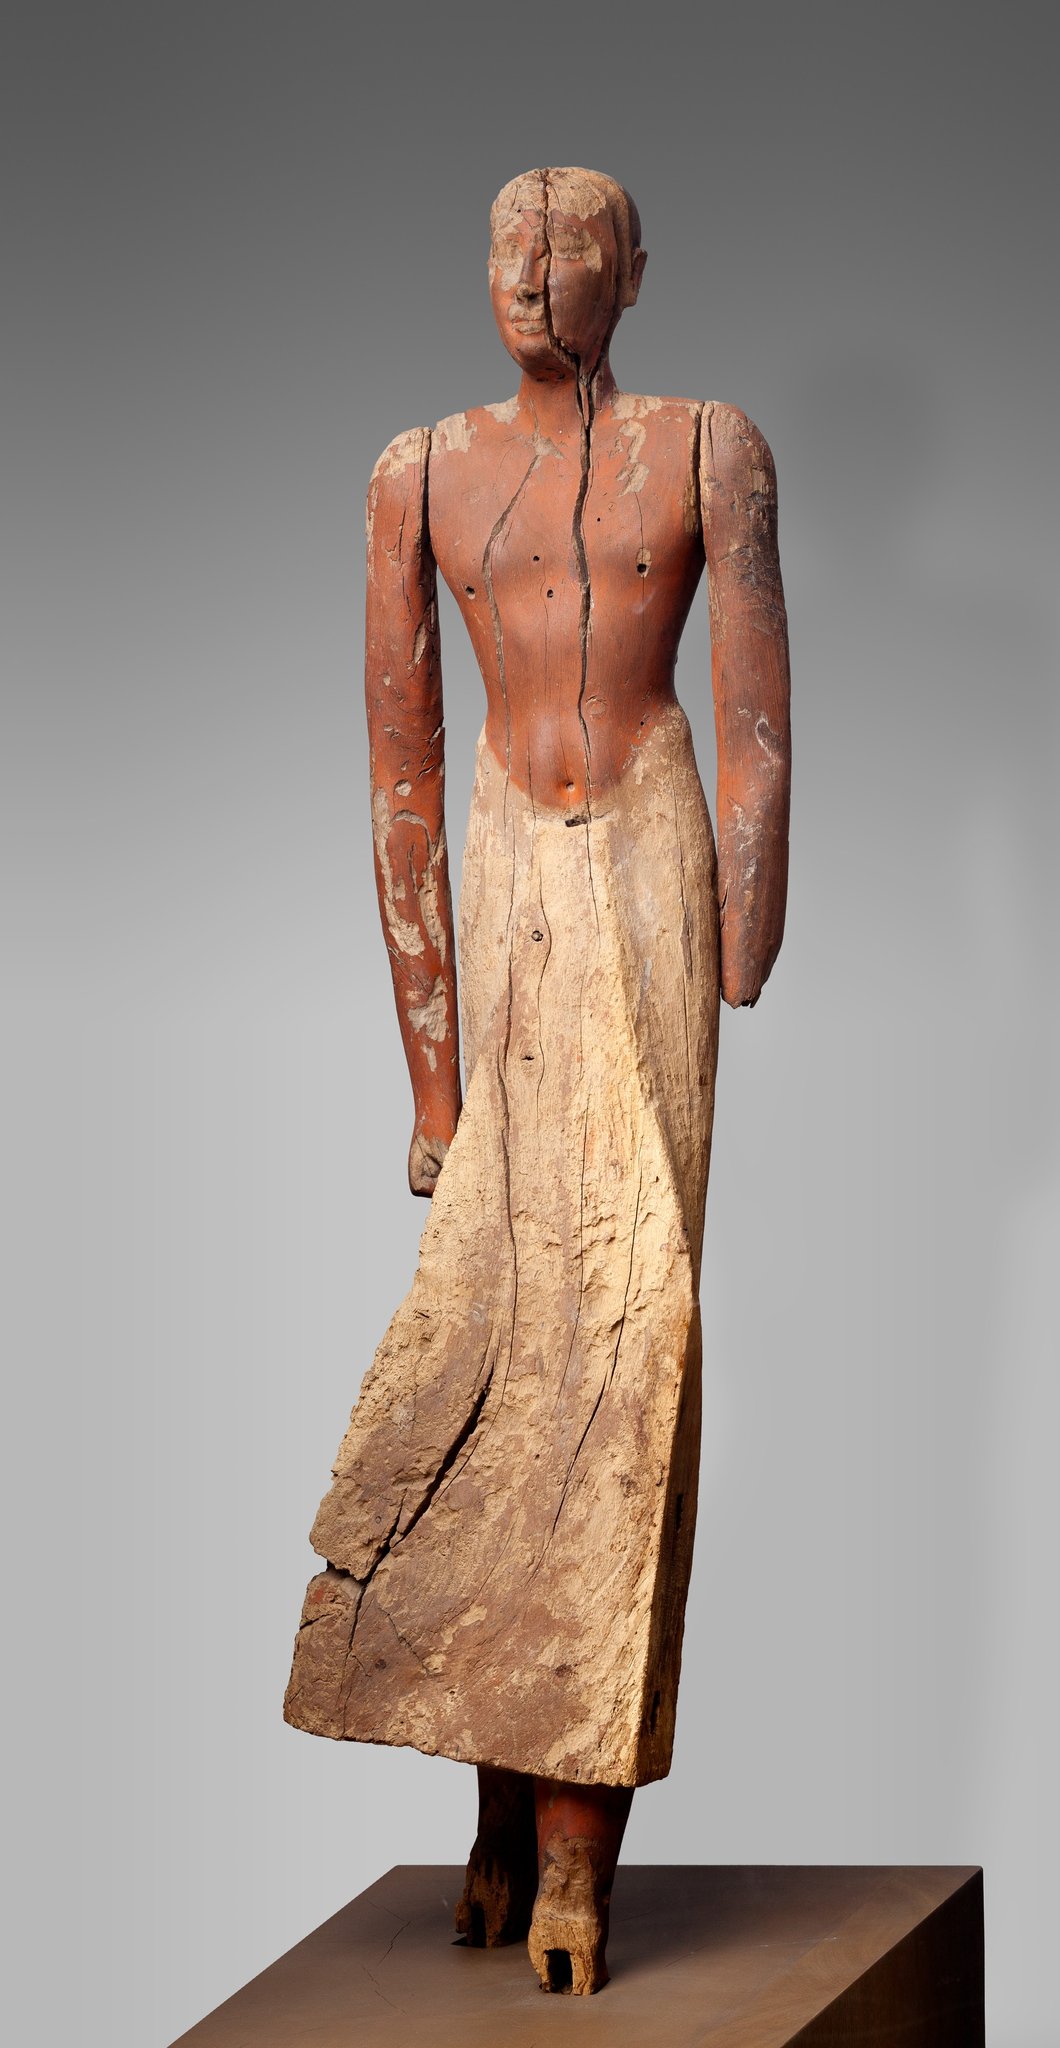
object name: statue, courtier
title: Statue of an official Ihy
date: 2200-2100 BCE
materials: paint, wood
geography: egypt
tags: men,portraits